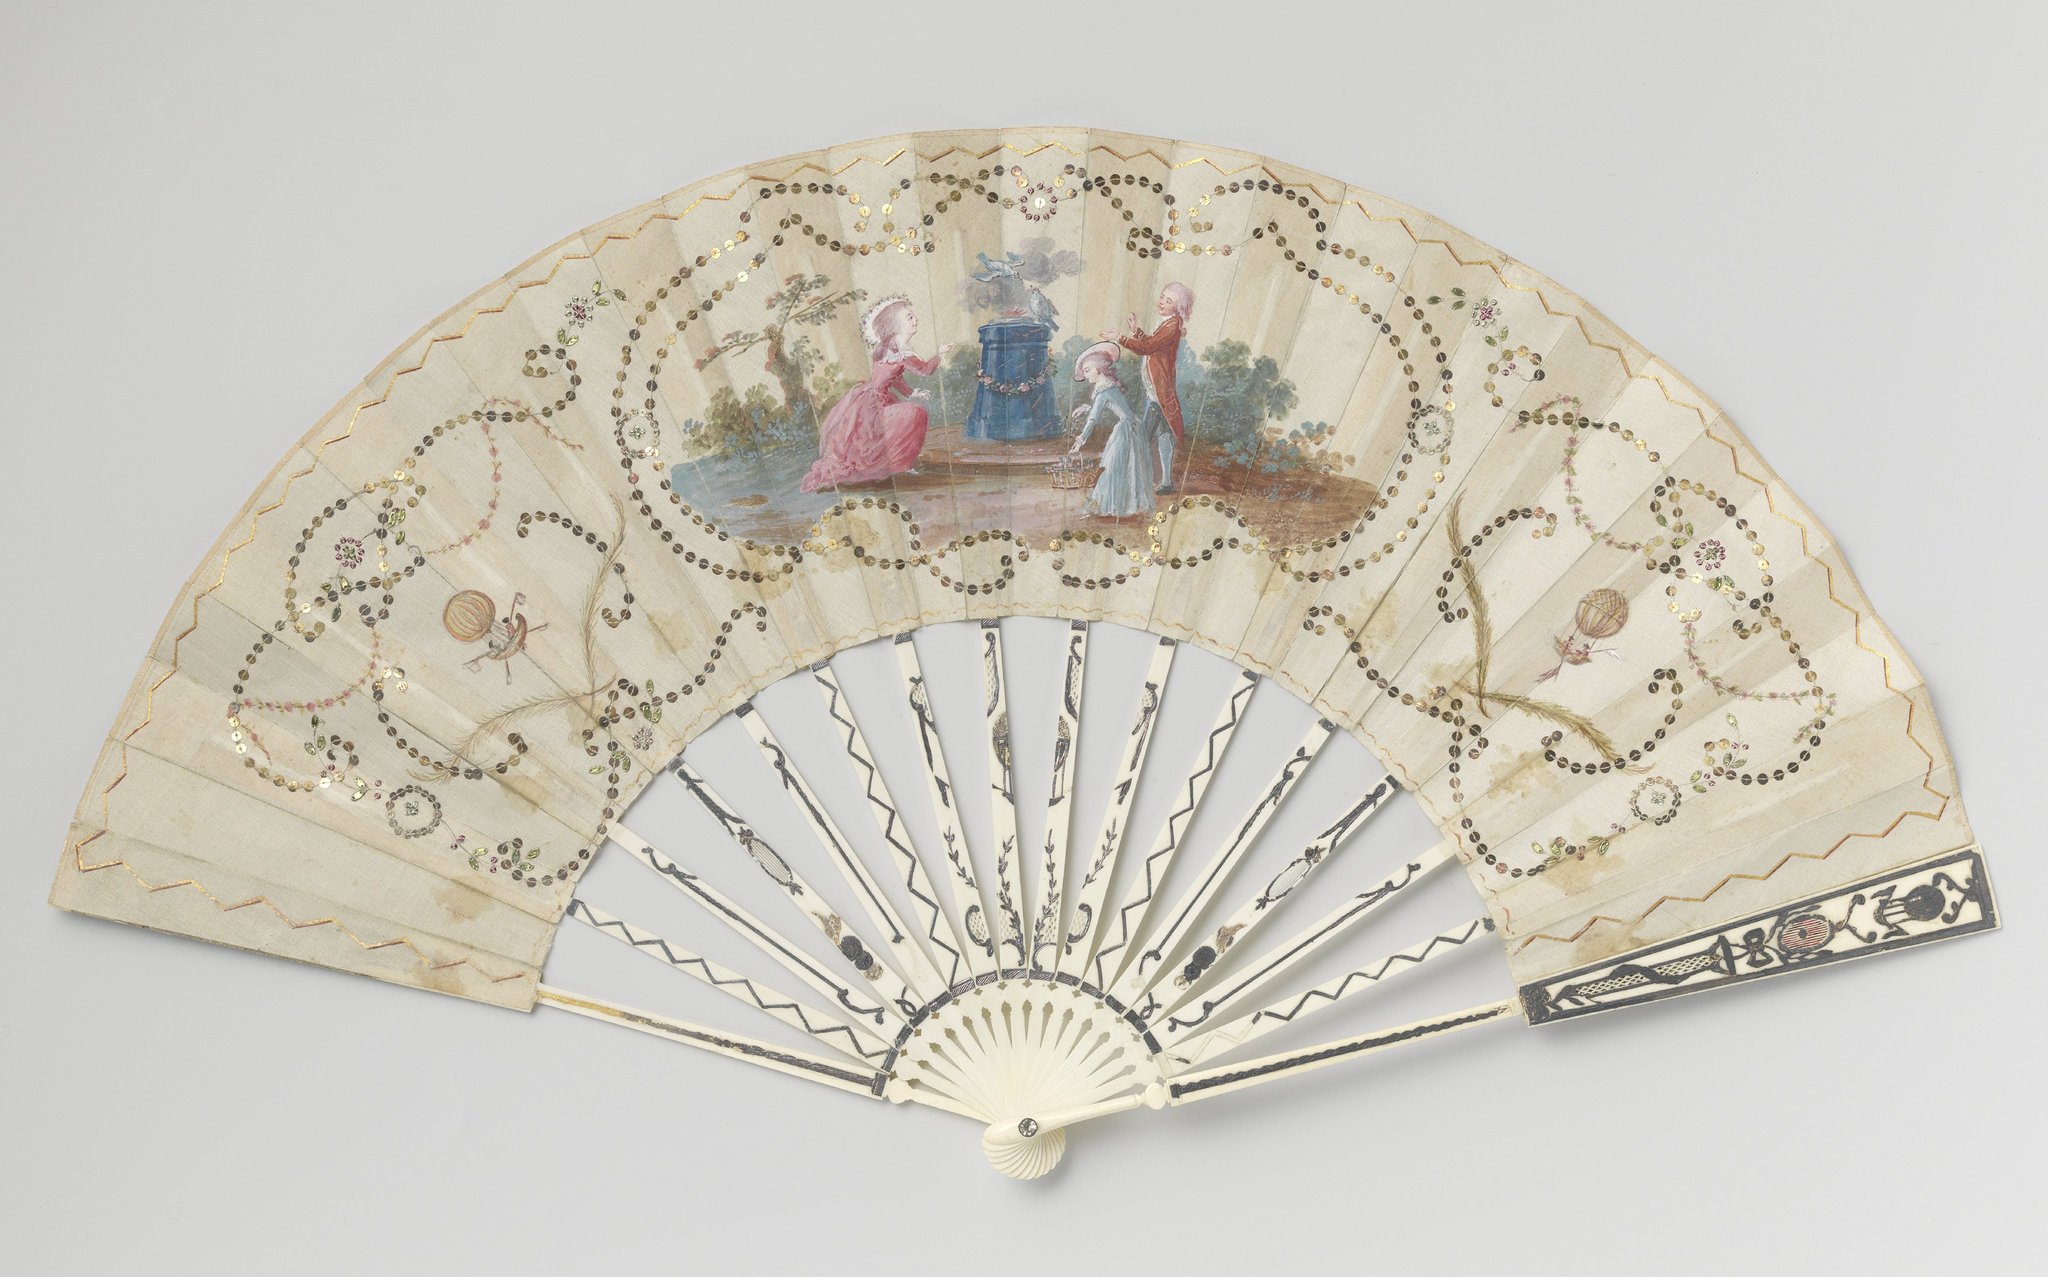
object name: vouwwaaier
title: Vouwwaaier met blad van zijde waarop in gouache een gezelschap bij een liefdesaltaar met brandend hart en tortelduiven en aan weerszijden de ballon van de gebroeders Montgolfier omgeven door metalen lovertjes, op een montuur van been ingelegd met 'métal en quattre couleurs'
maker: Anonymous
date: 1783-1784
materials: bone, glass, gouache, metal, paint, silk, silver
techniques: cutting, manufacturing, grinding, inlay, weave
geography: france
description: Vouwwaaier, met blad van zijde waarop in gouache een gezelschap bij een liefdesaltaar met brandend hart en tortelduiven en aan weerszijden de ballon van de gebroeders Montgolfier omgeven door metalen lovers, op een montuur van been ingelegd met 'métal en quattre couleurs'. Aan het begin van de jaren 1780 waren zijden en satijnen waaierbladen versierd met lovers en pailletten volop in de mode in Frankrijk. De meeste bewaard gebleven waaiers '(éventail) au ballon' hebben dan ook een blad van beige zijde, geschilderde voorstellingen en versieringen van al dan niet gekleurde metalen lovertjes. Op de achterkant van dit enkele blad, gemonteerd à l'anglaise, is de ondertekening nog zichtbaar. Het historisch moment van de eerste ballonvlucht door de gebroeders Montgolfier, op 1 december 1783, wordt meestal uitgebeeld met de voor de vlucht gebruikte, half met een net bedekte, gestreepte ballon, waaronder een bootvormige gondel met de gebroeders, die ieder een stok met een wimpel in hun hand houden. De grote centrale cartouche toont een voorstelling die niets met de ballonvaart te maken heeft; namelijk, het bekende huwelijksthema dat met behulp van de traditionele symboliek is uitgebeeld. Een huwelijksaltaar waarop twee brandende harten en twee tortelduiven, omringd door offerende mensen. De combinatie van 'huwelijk' met 'luchtballon' lijkt tegenwoordig nogal ongebruikelijk, maar gezien het aantal bewaard gebleven voorbeelden moet het door tijdgenoten niet als vreemd ervaren zijn.